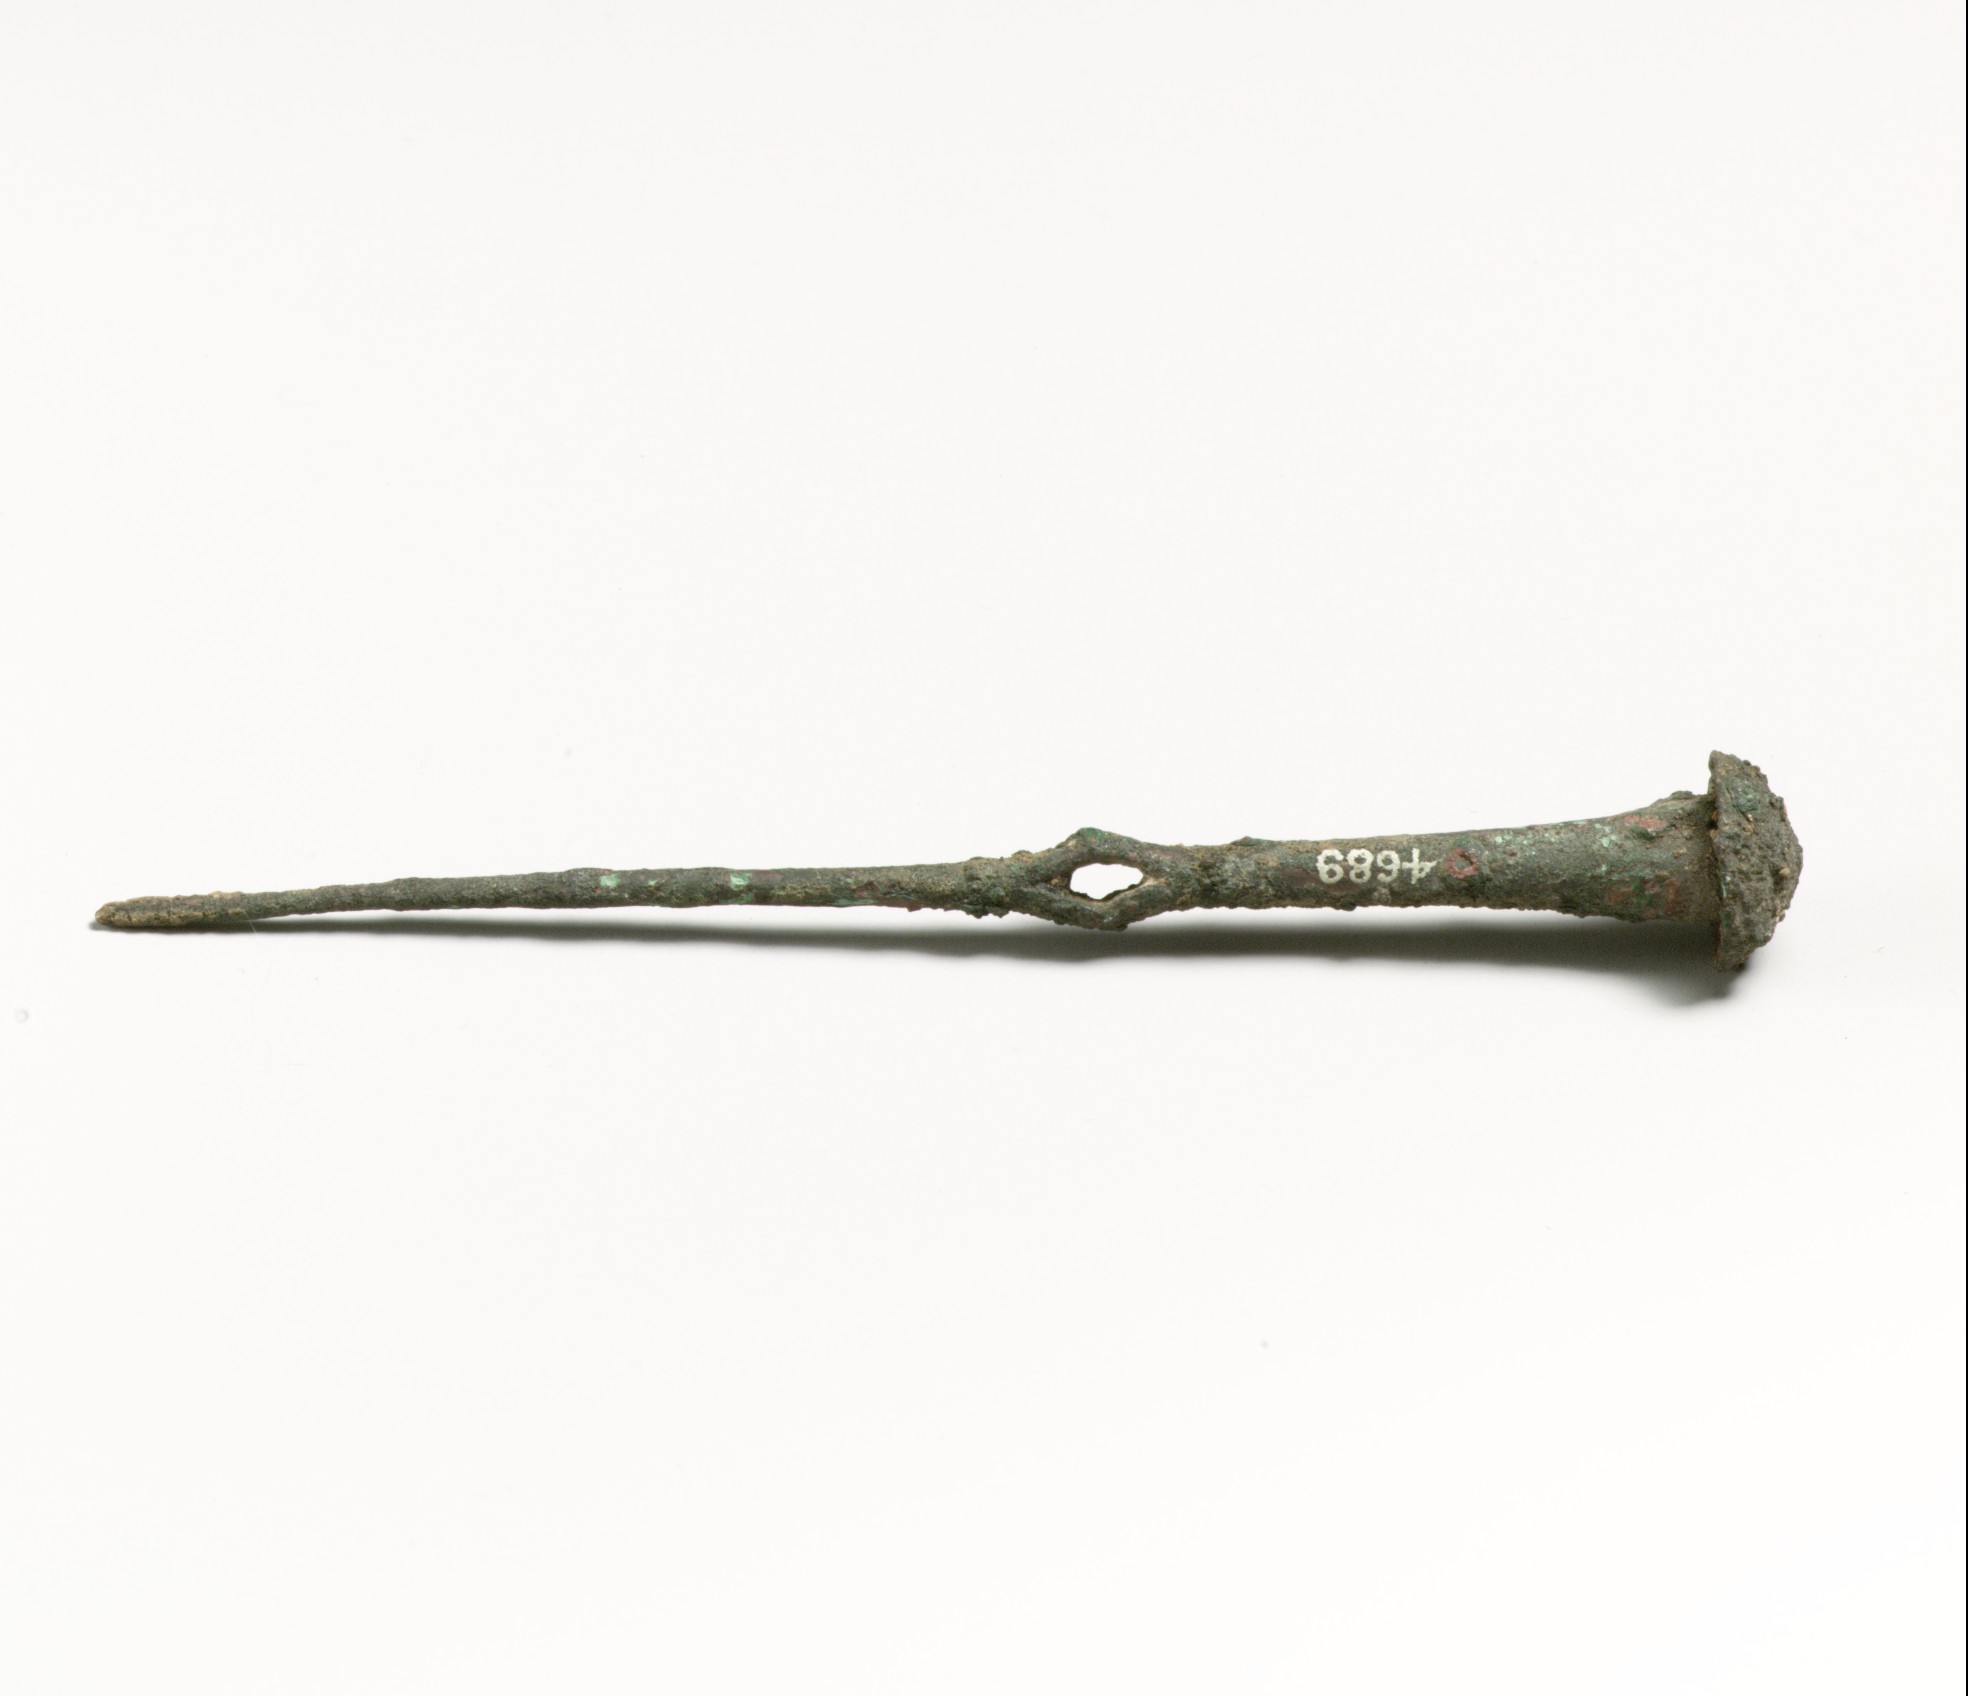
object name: pin, eyelet type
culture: cypriot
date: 3900 BCE-100 CE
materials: bronze